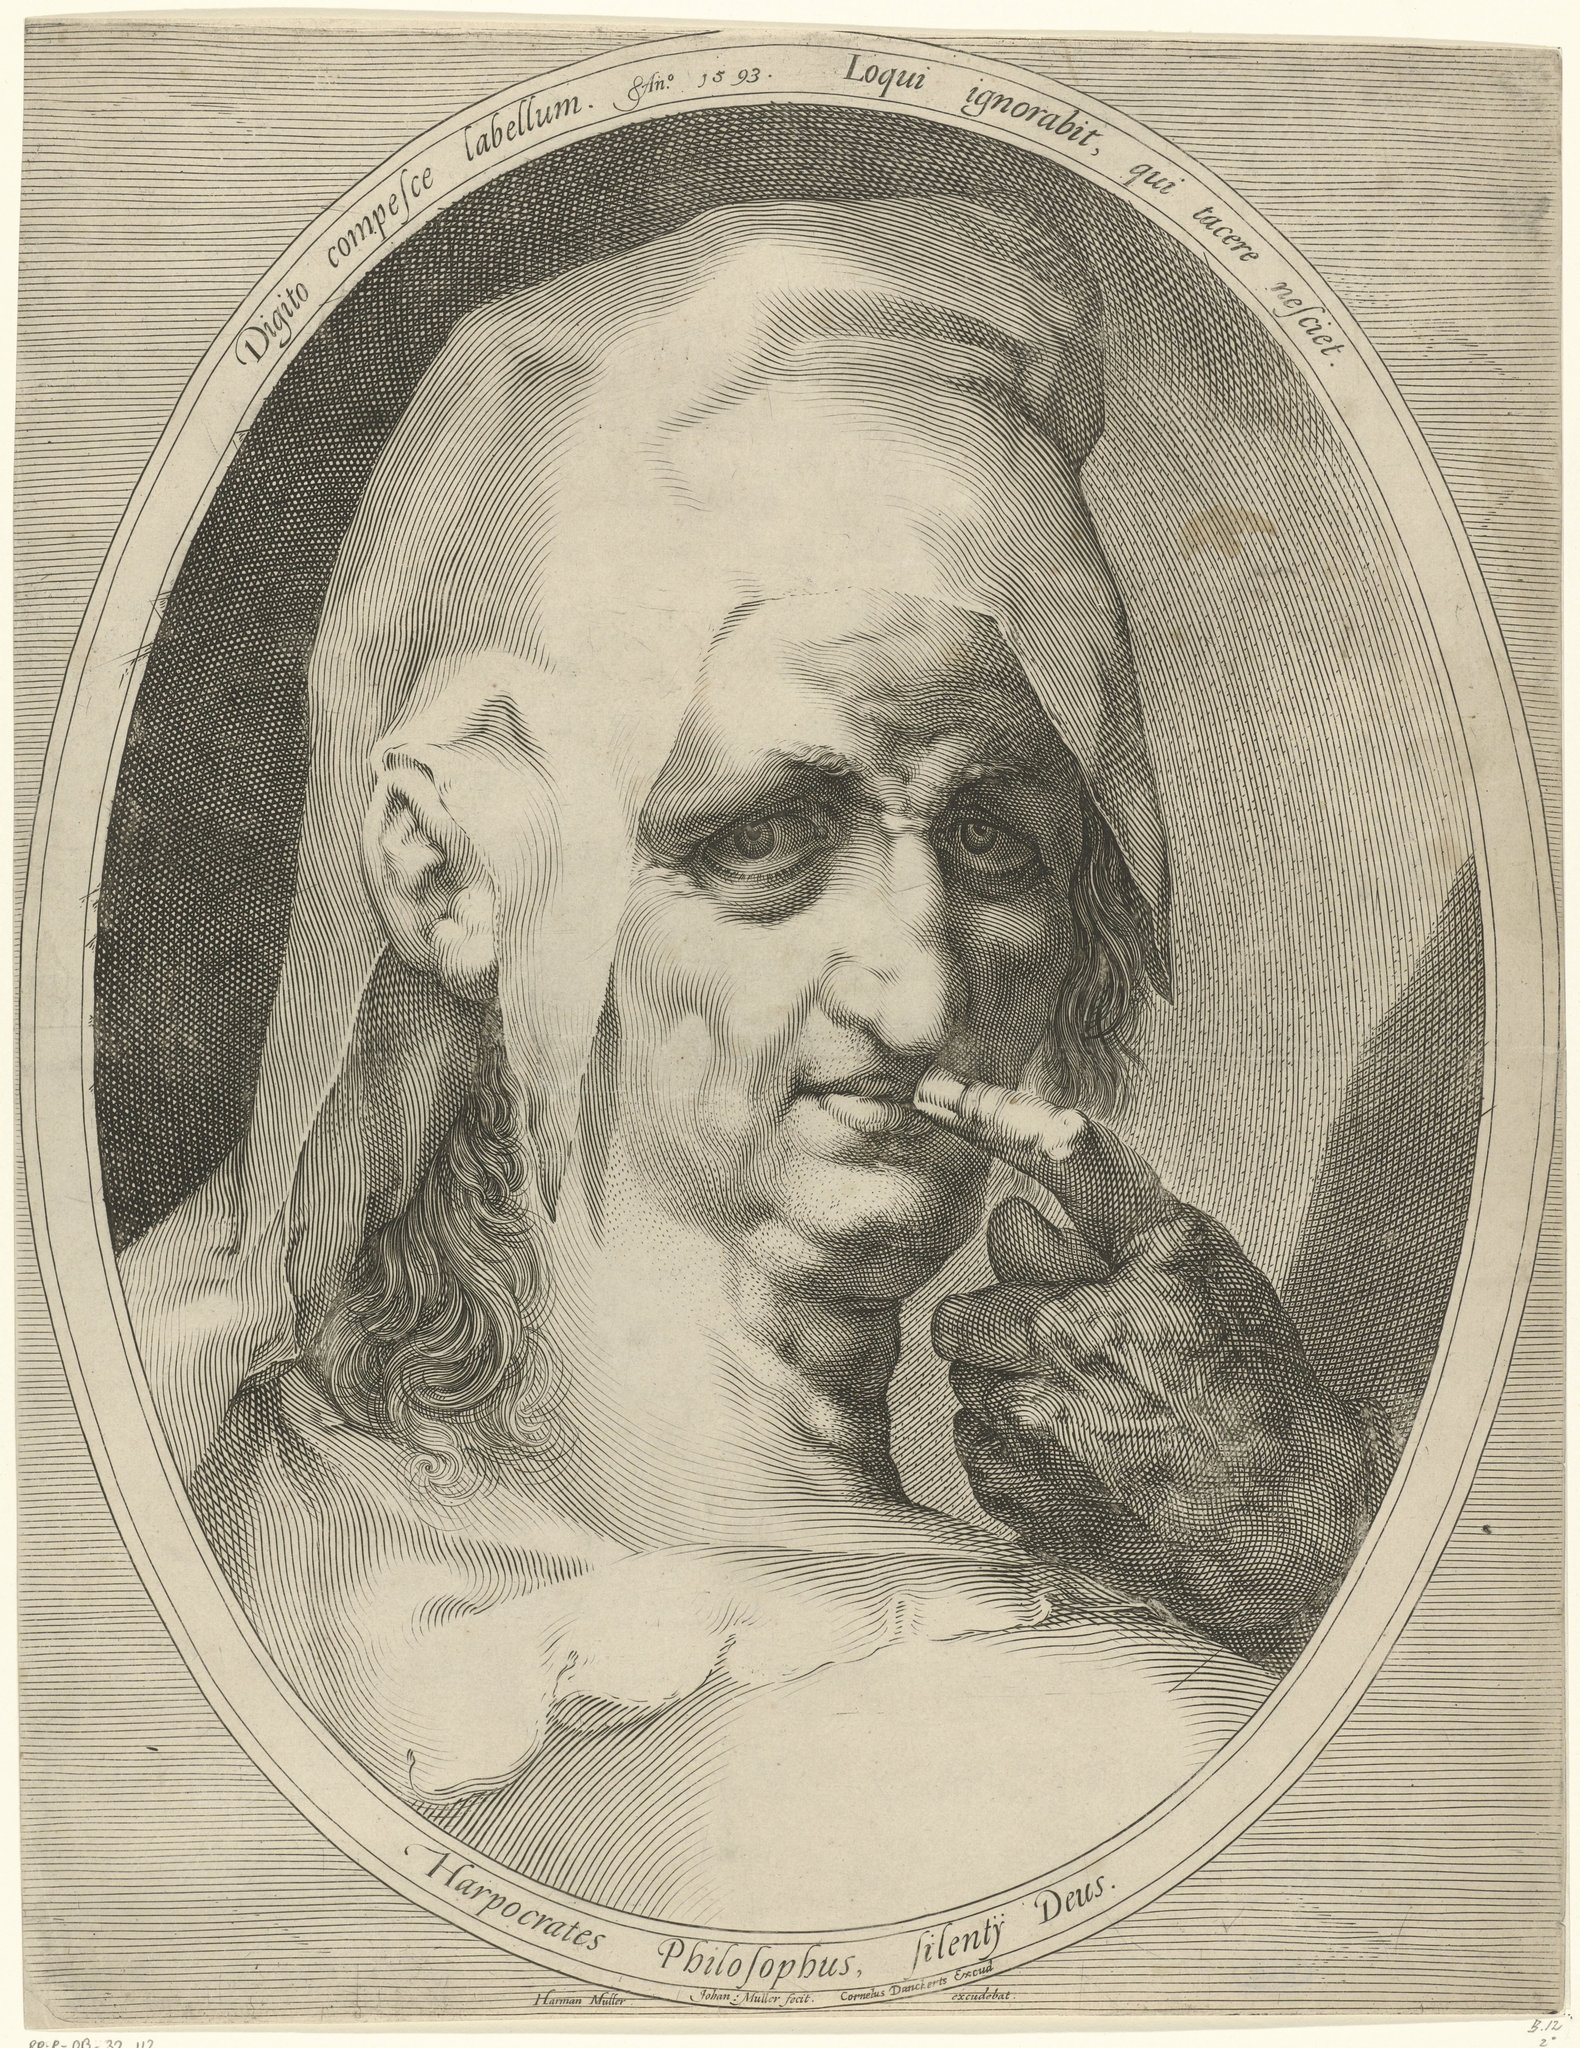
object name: print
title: Harpocrates, Philosophus, Silentii Deus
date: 1593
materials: paper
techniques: engraving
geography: amsterdam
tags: putting a finger to the lips, 'silentium'; 'silentio' (ripa), harpocrates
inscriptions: collector's mark: Lugt 2228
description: Harpocrates, de god van de stilte, houdt zijn vinger tegen zijn lippen.